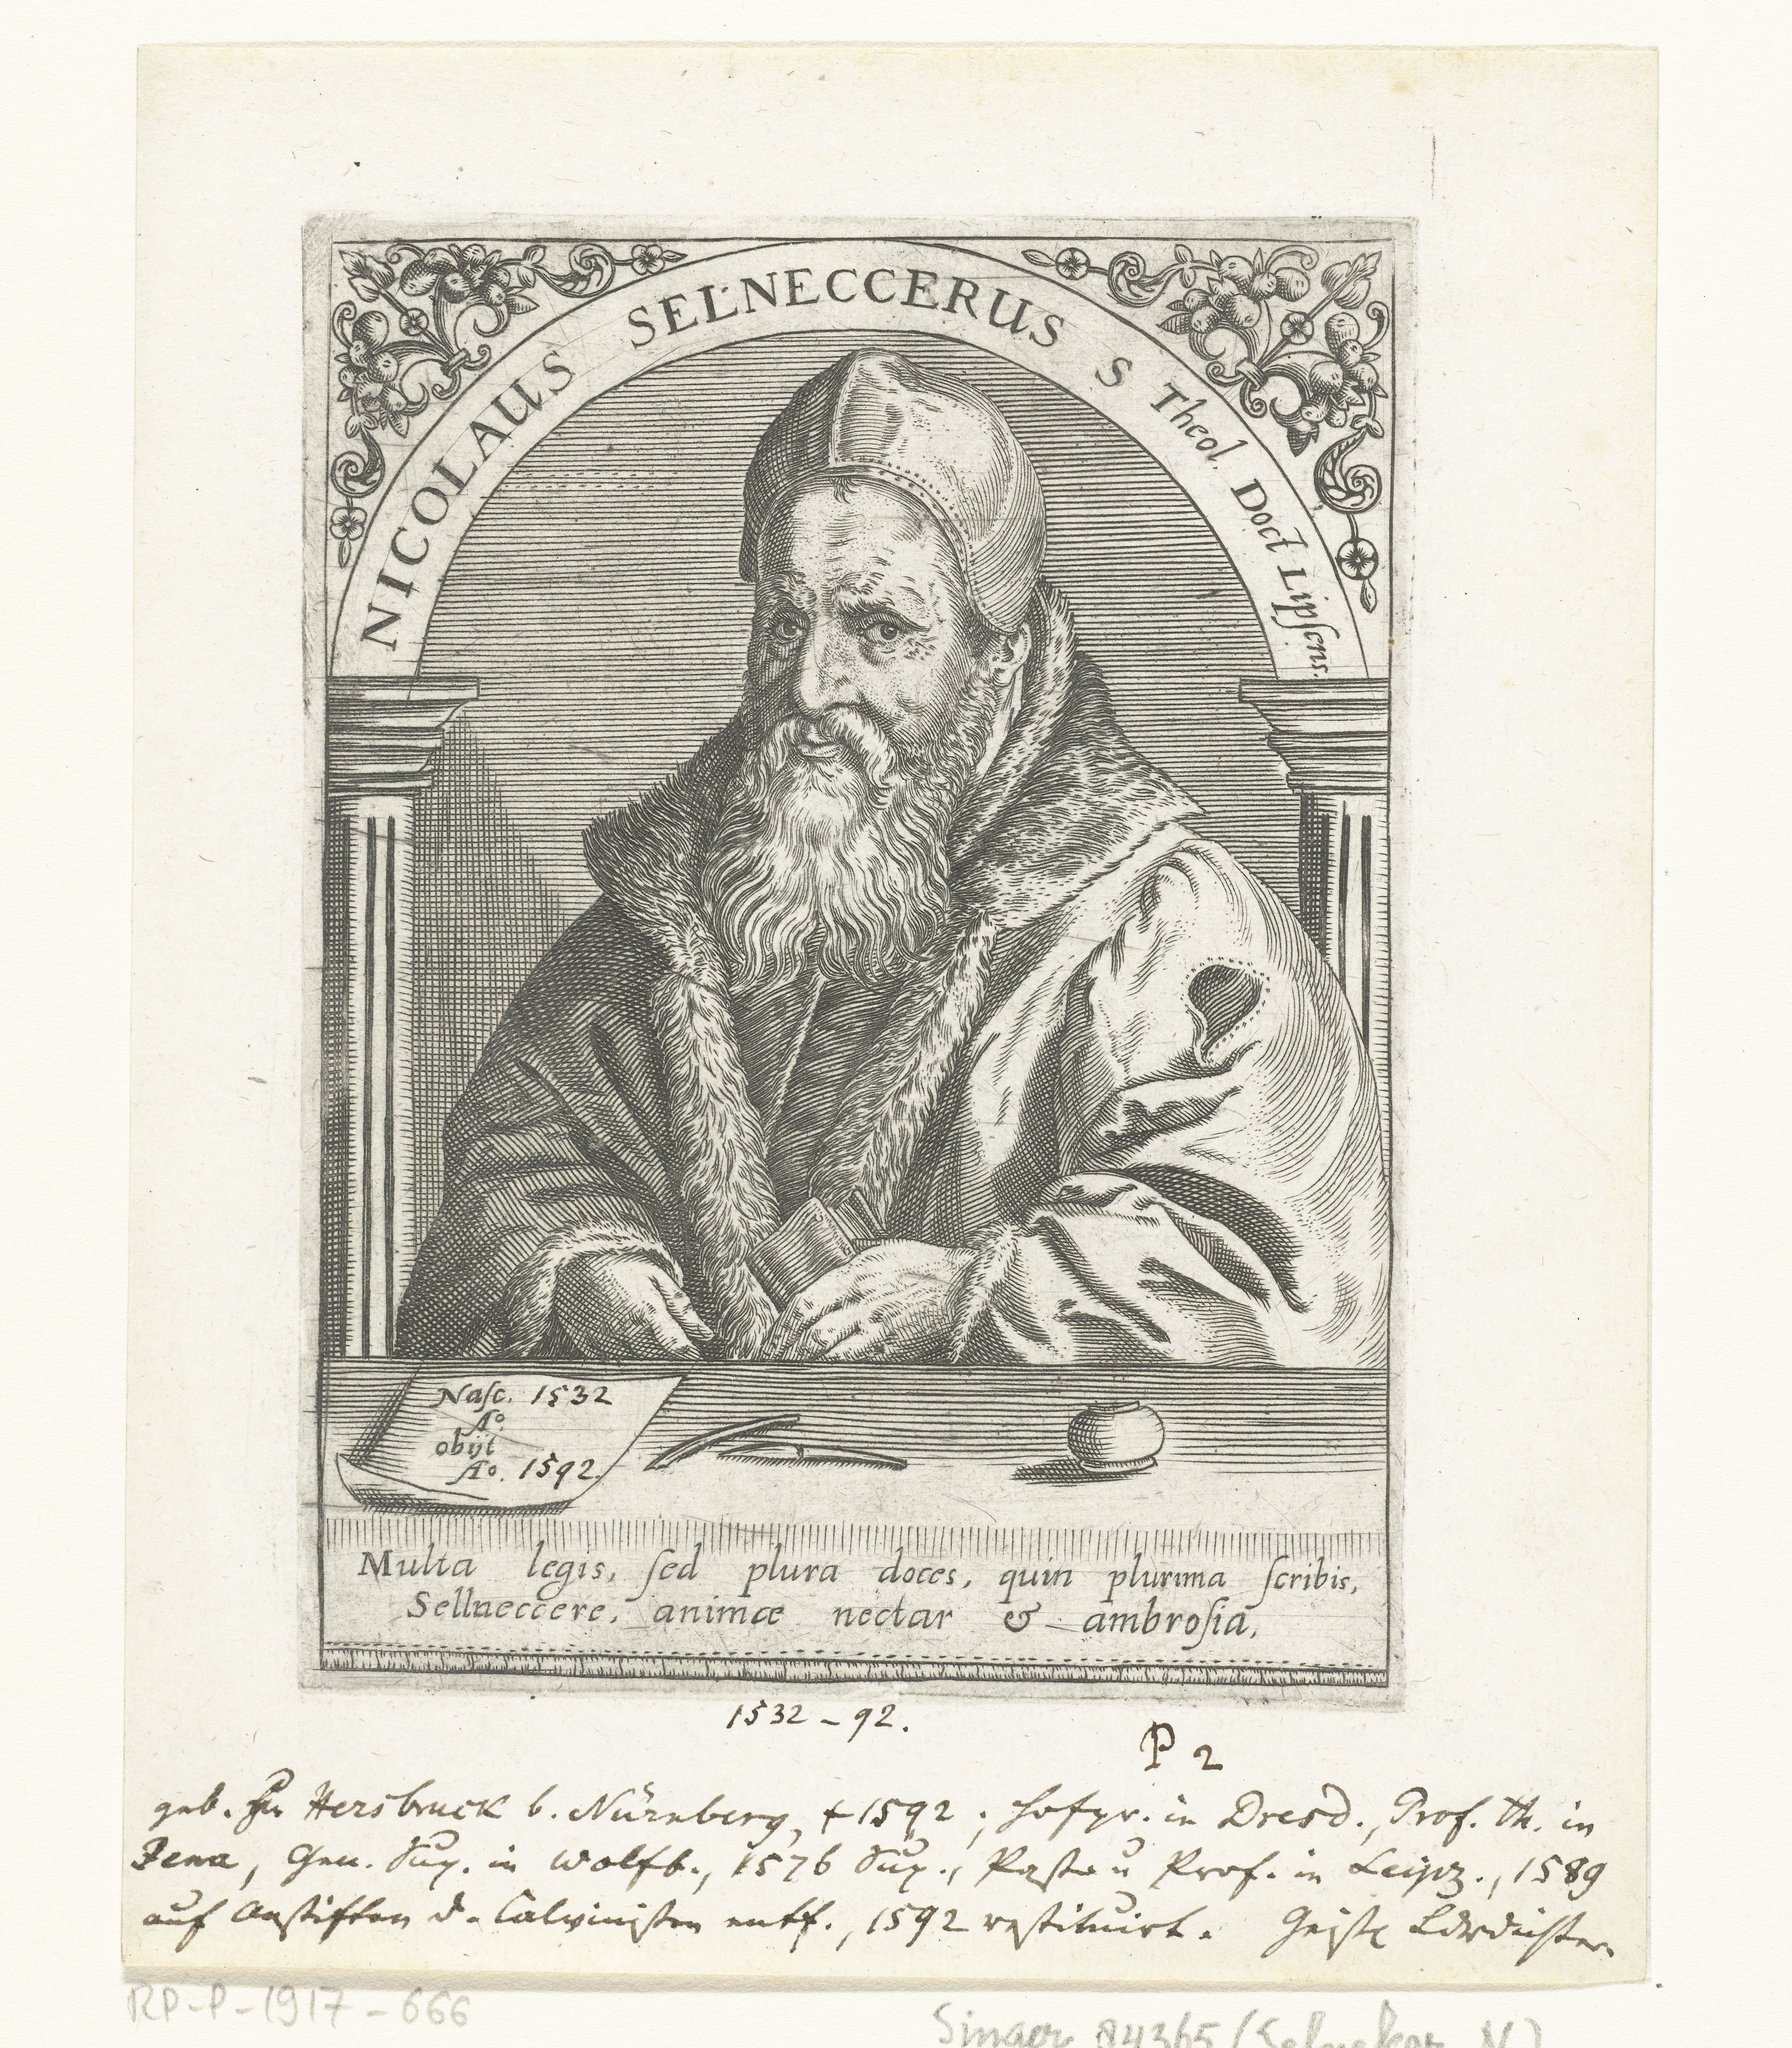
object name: book illustration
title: Nicolaus Selneccerus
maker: johann theodor de bry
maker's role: print maker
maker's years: 1561-1623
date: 1669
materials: paper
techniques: engraving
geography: frankfurt am main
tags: theoloog, hoogleraar, nikolaus selnecker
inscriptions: collector's mark: Lugt 2228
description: Gemaakt voor: J.J. Boissard, Icones virorum illustrium doctrina &c eruditione praestanti um contines. Frankfurt am Main: de Bry, 1597-1599. Opnieuw gebruikt in: J.J.Boissard, Bibliotheca chalcographica, hoc est Virtute et eruditione clarorum Virorum Imagines. Heidelberg: Clemens Ammon, 1669 (te herkennen aan de toegevoegde signatuur in de rechter onderhoek: S3).